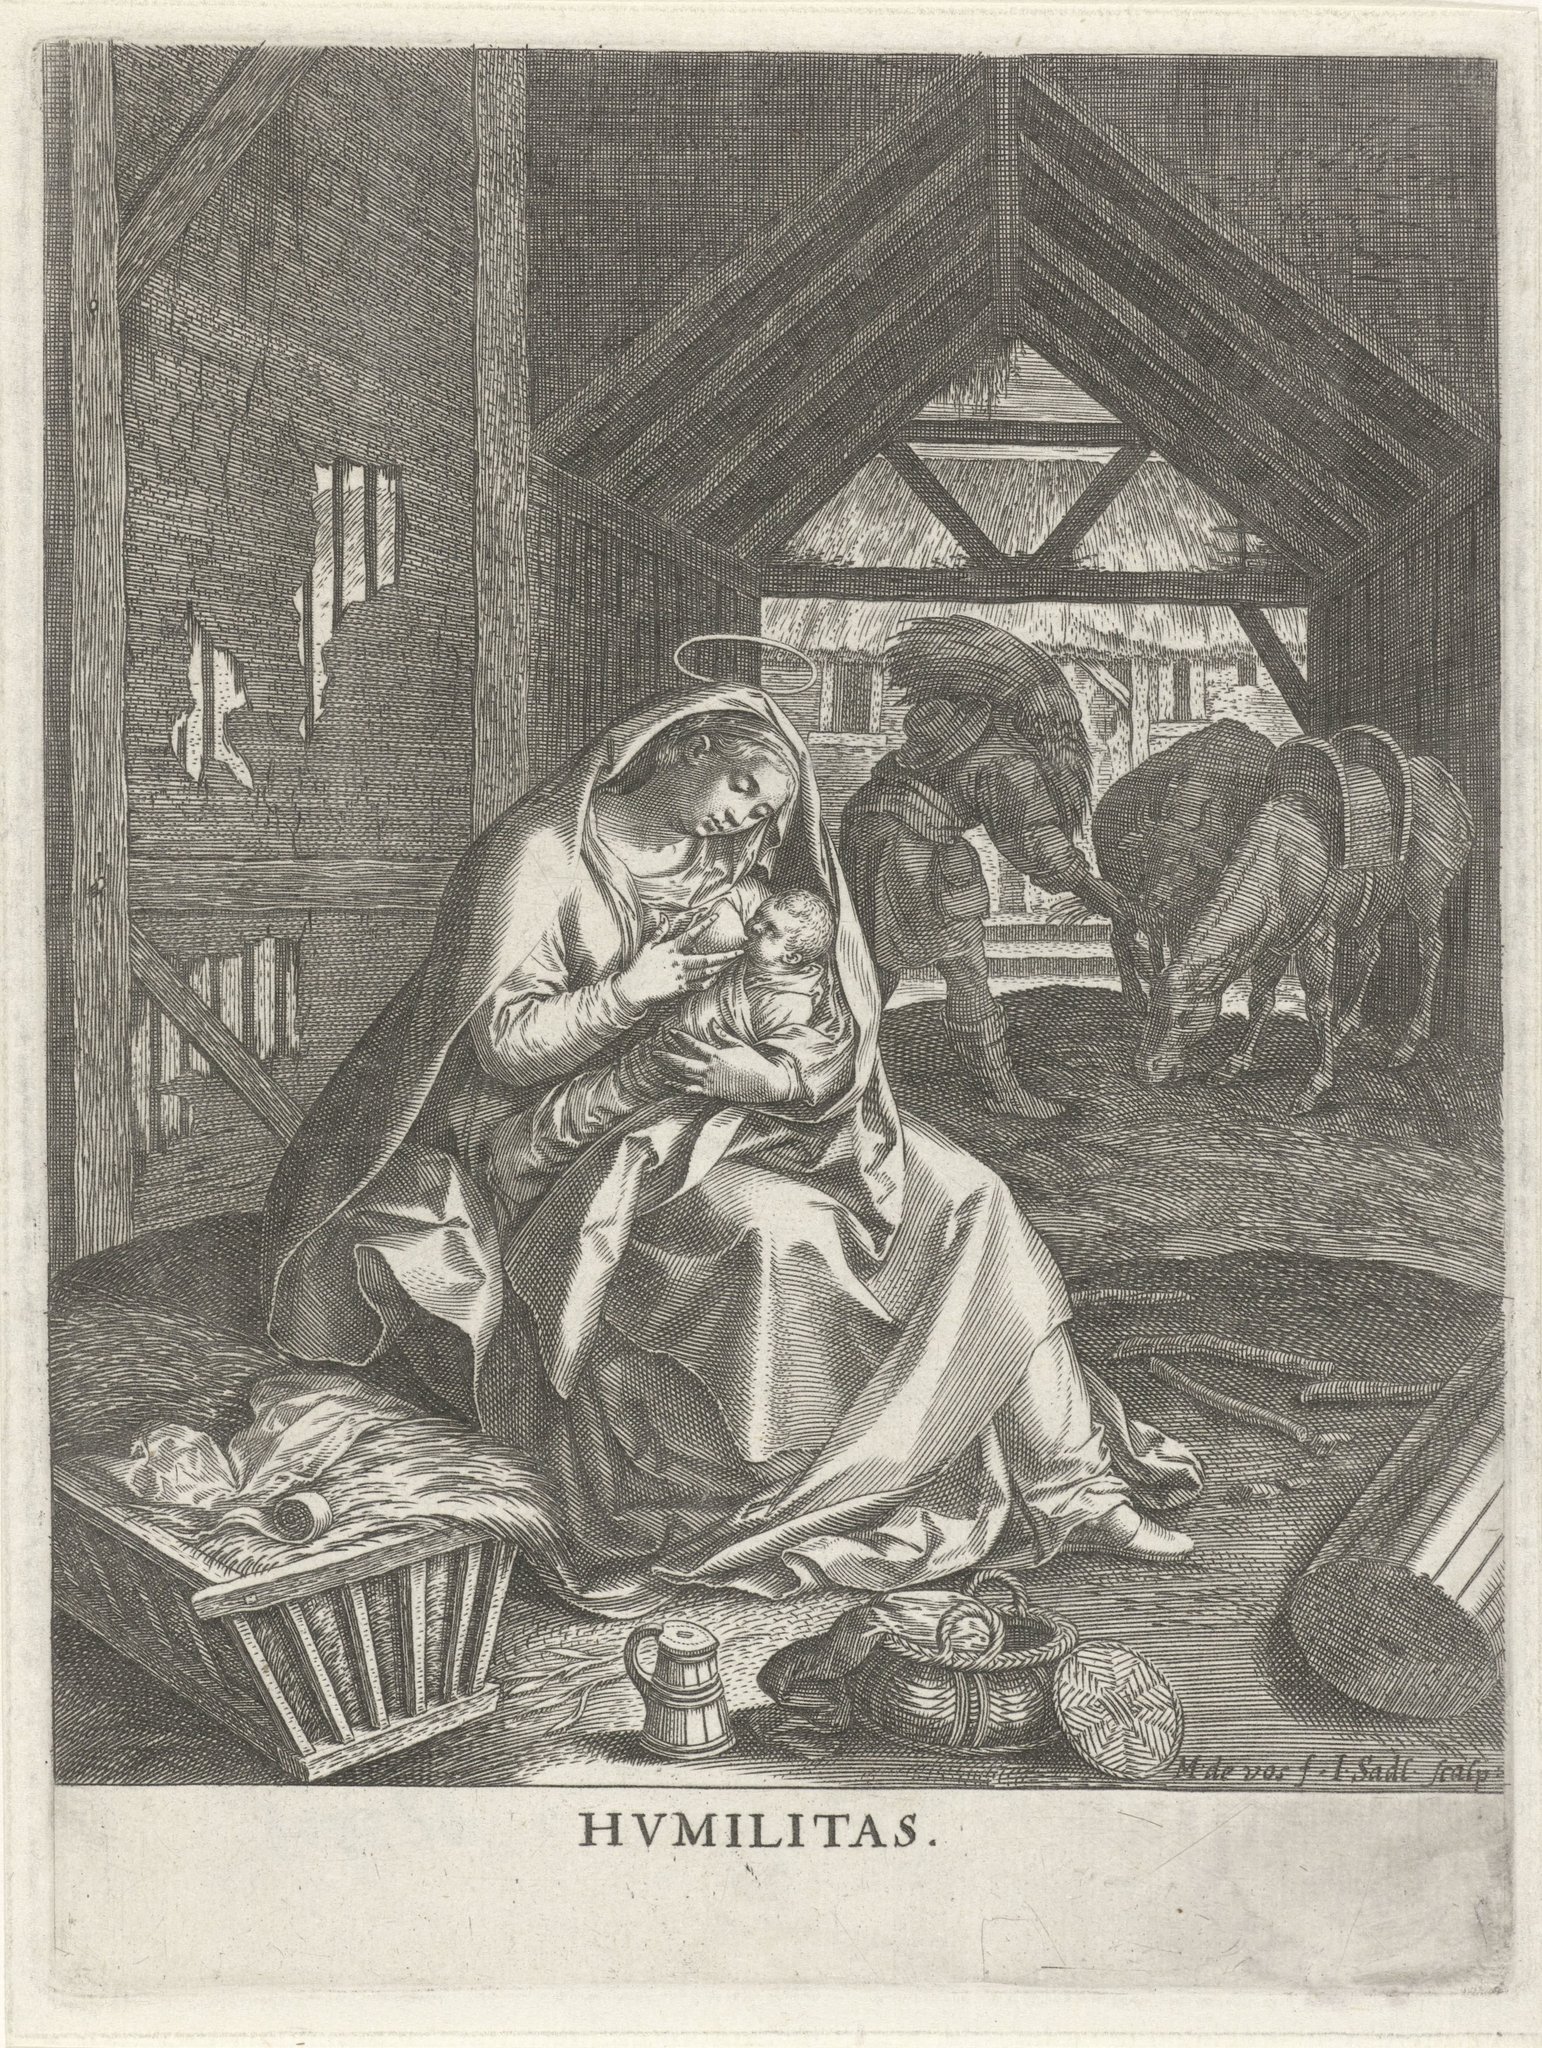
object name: print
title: Maria voedt het Christuskind: nederigheid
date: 1585-1588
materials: paper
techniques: engraving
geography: munich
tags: care of the new-born christ-child, e.g. swaddling, christ-child suckling, or beginning to suckle, e.g. mary uncovering her breast ~ madonna-representations, humility; 'humiltà' (ripa)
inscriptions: collector's mark: Lugt 240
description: In een stal geeft de maagd Maria het Christuskind de borst. Naast haar de kribbe. Op de achtergrond voedert Jozef de os en de ezel. De eerste prent van een achtdelige serie met scènes uit het leven van Christus die zijn belangrijkste deugden verbeelden.